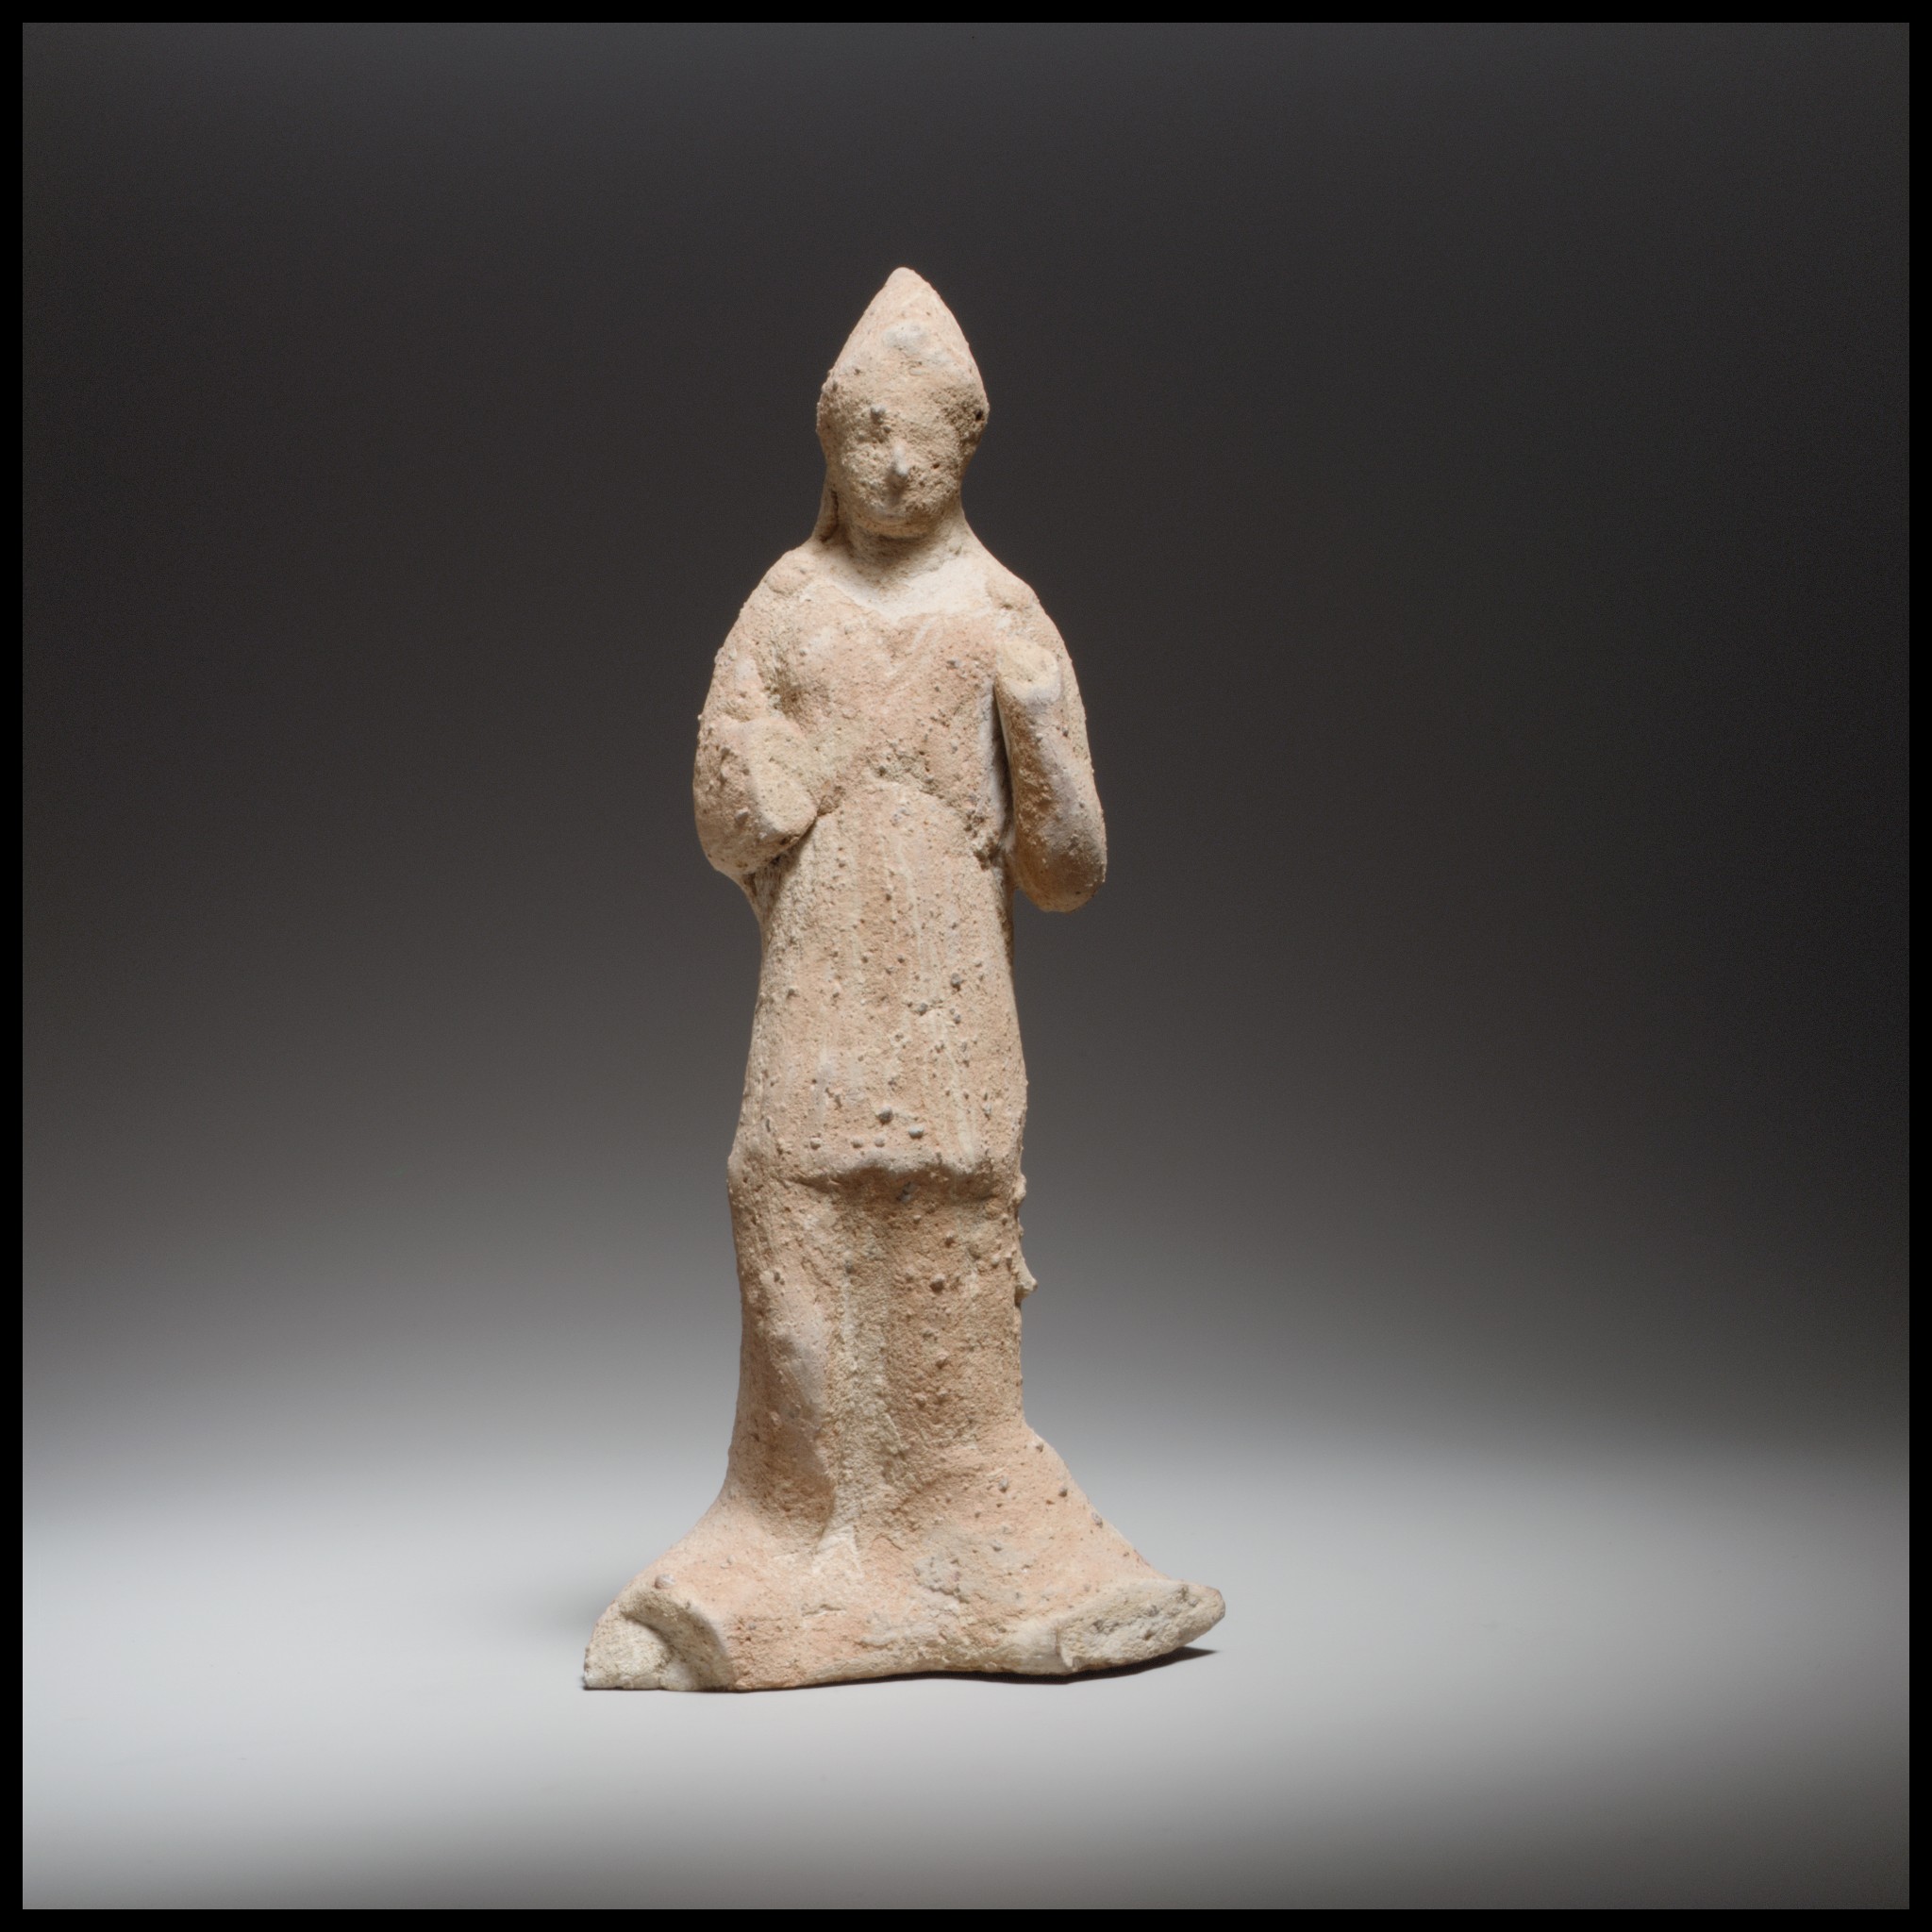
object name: statuette of a female from a ring dance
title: Standing female figurine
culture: cypriot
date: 300-201 BCE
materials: terracotta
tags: women